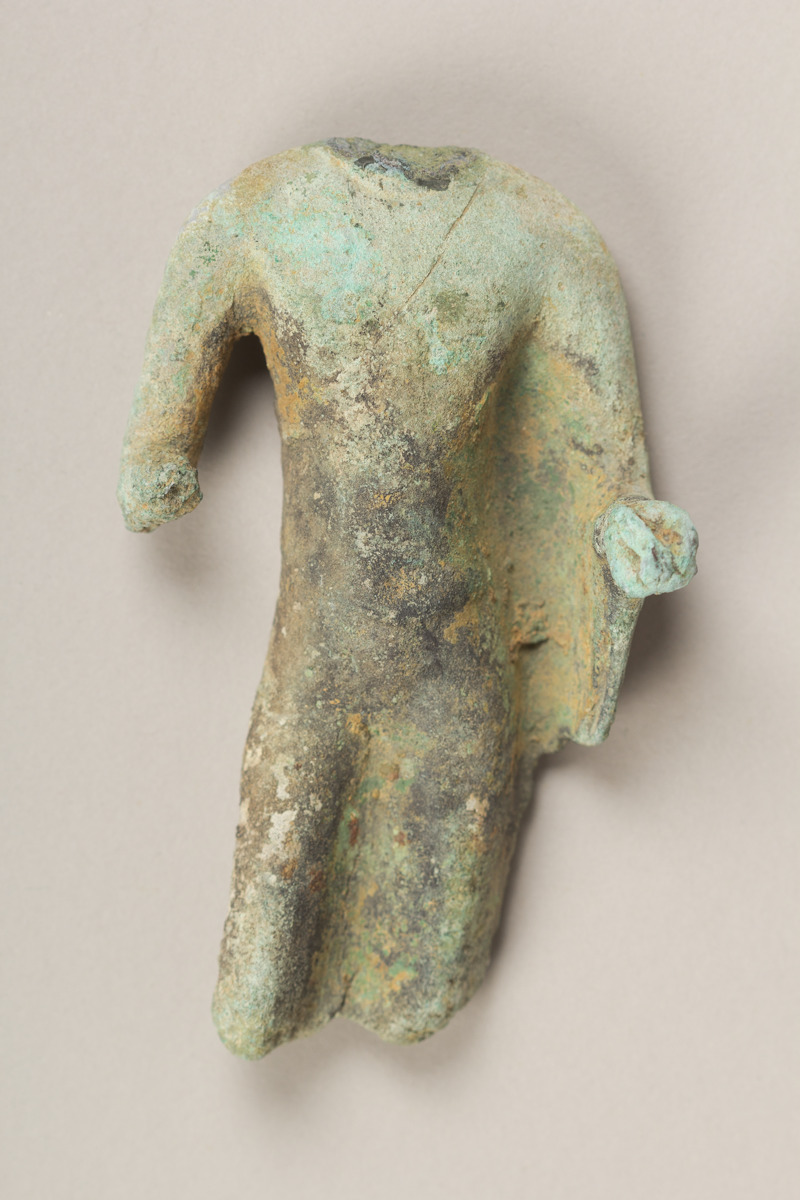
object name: fragment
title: Fragment of a Torso of Buddha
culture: indonesian, kalimantan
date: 701-800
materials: bronze